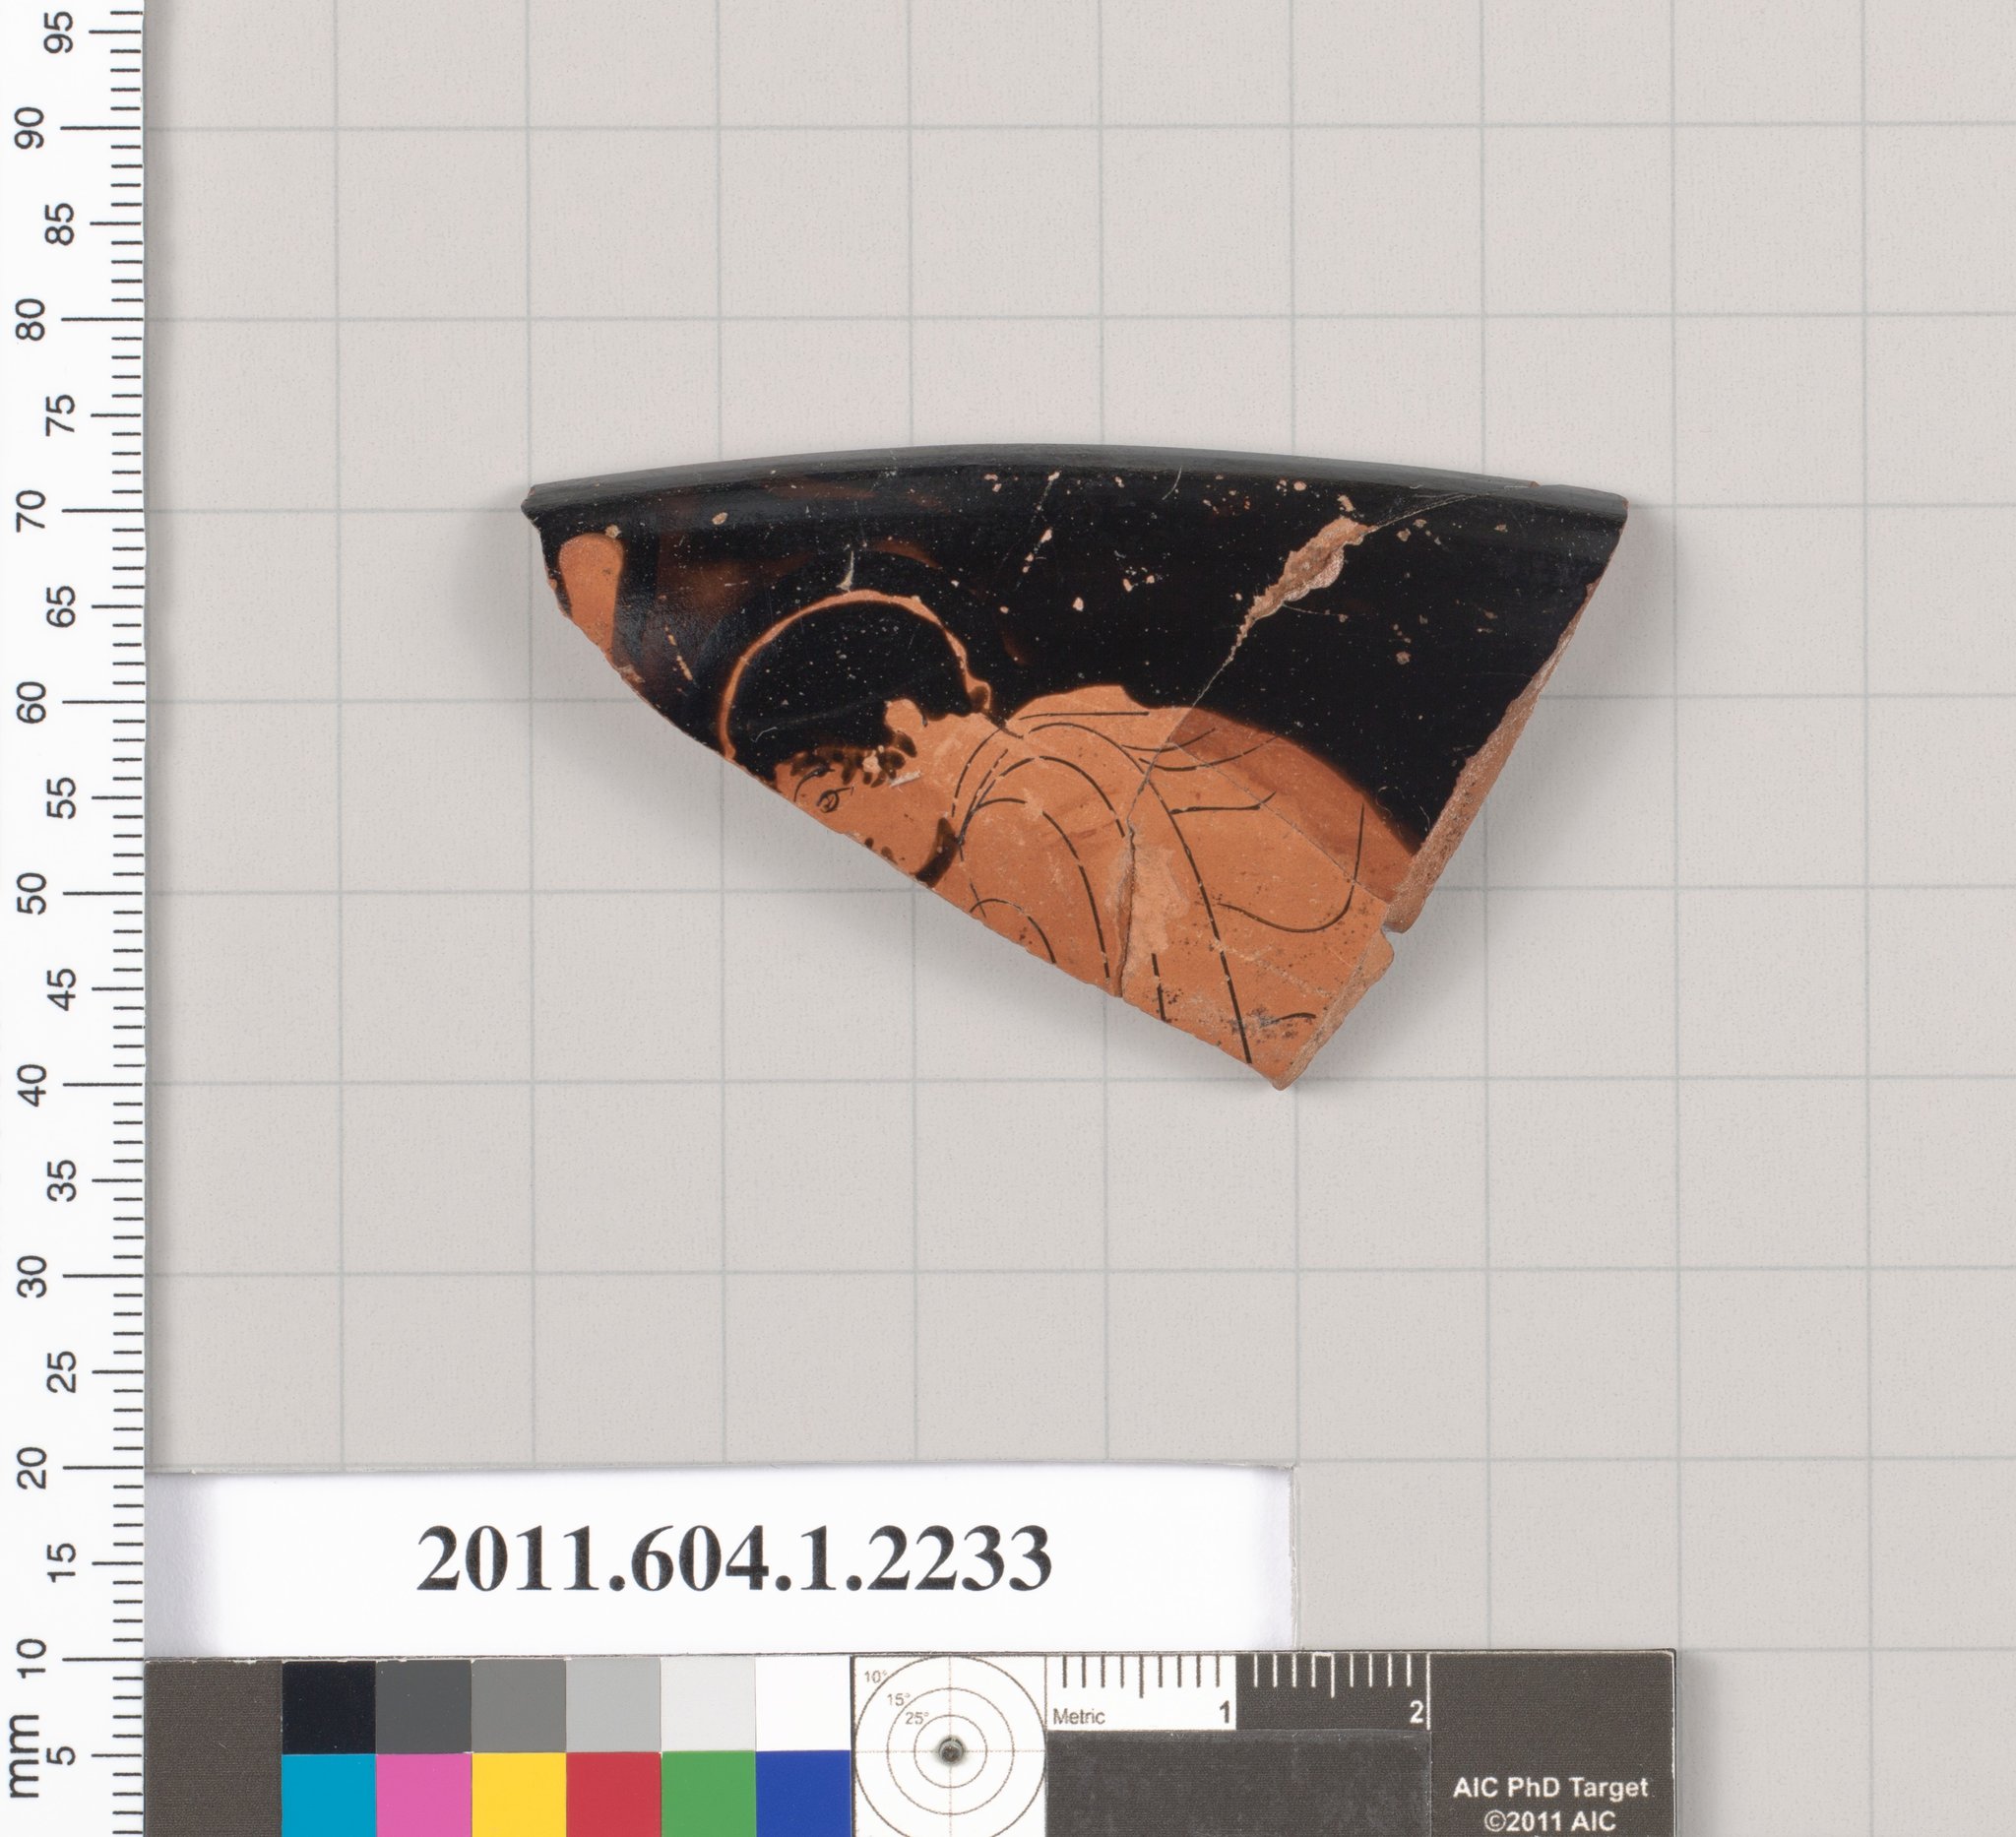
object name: kylix fragment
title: Terracotta rim fragment of a kylix (drinking cup)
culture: greek, attic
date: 475-451 BCE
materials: terracotta